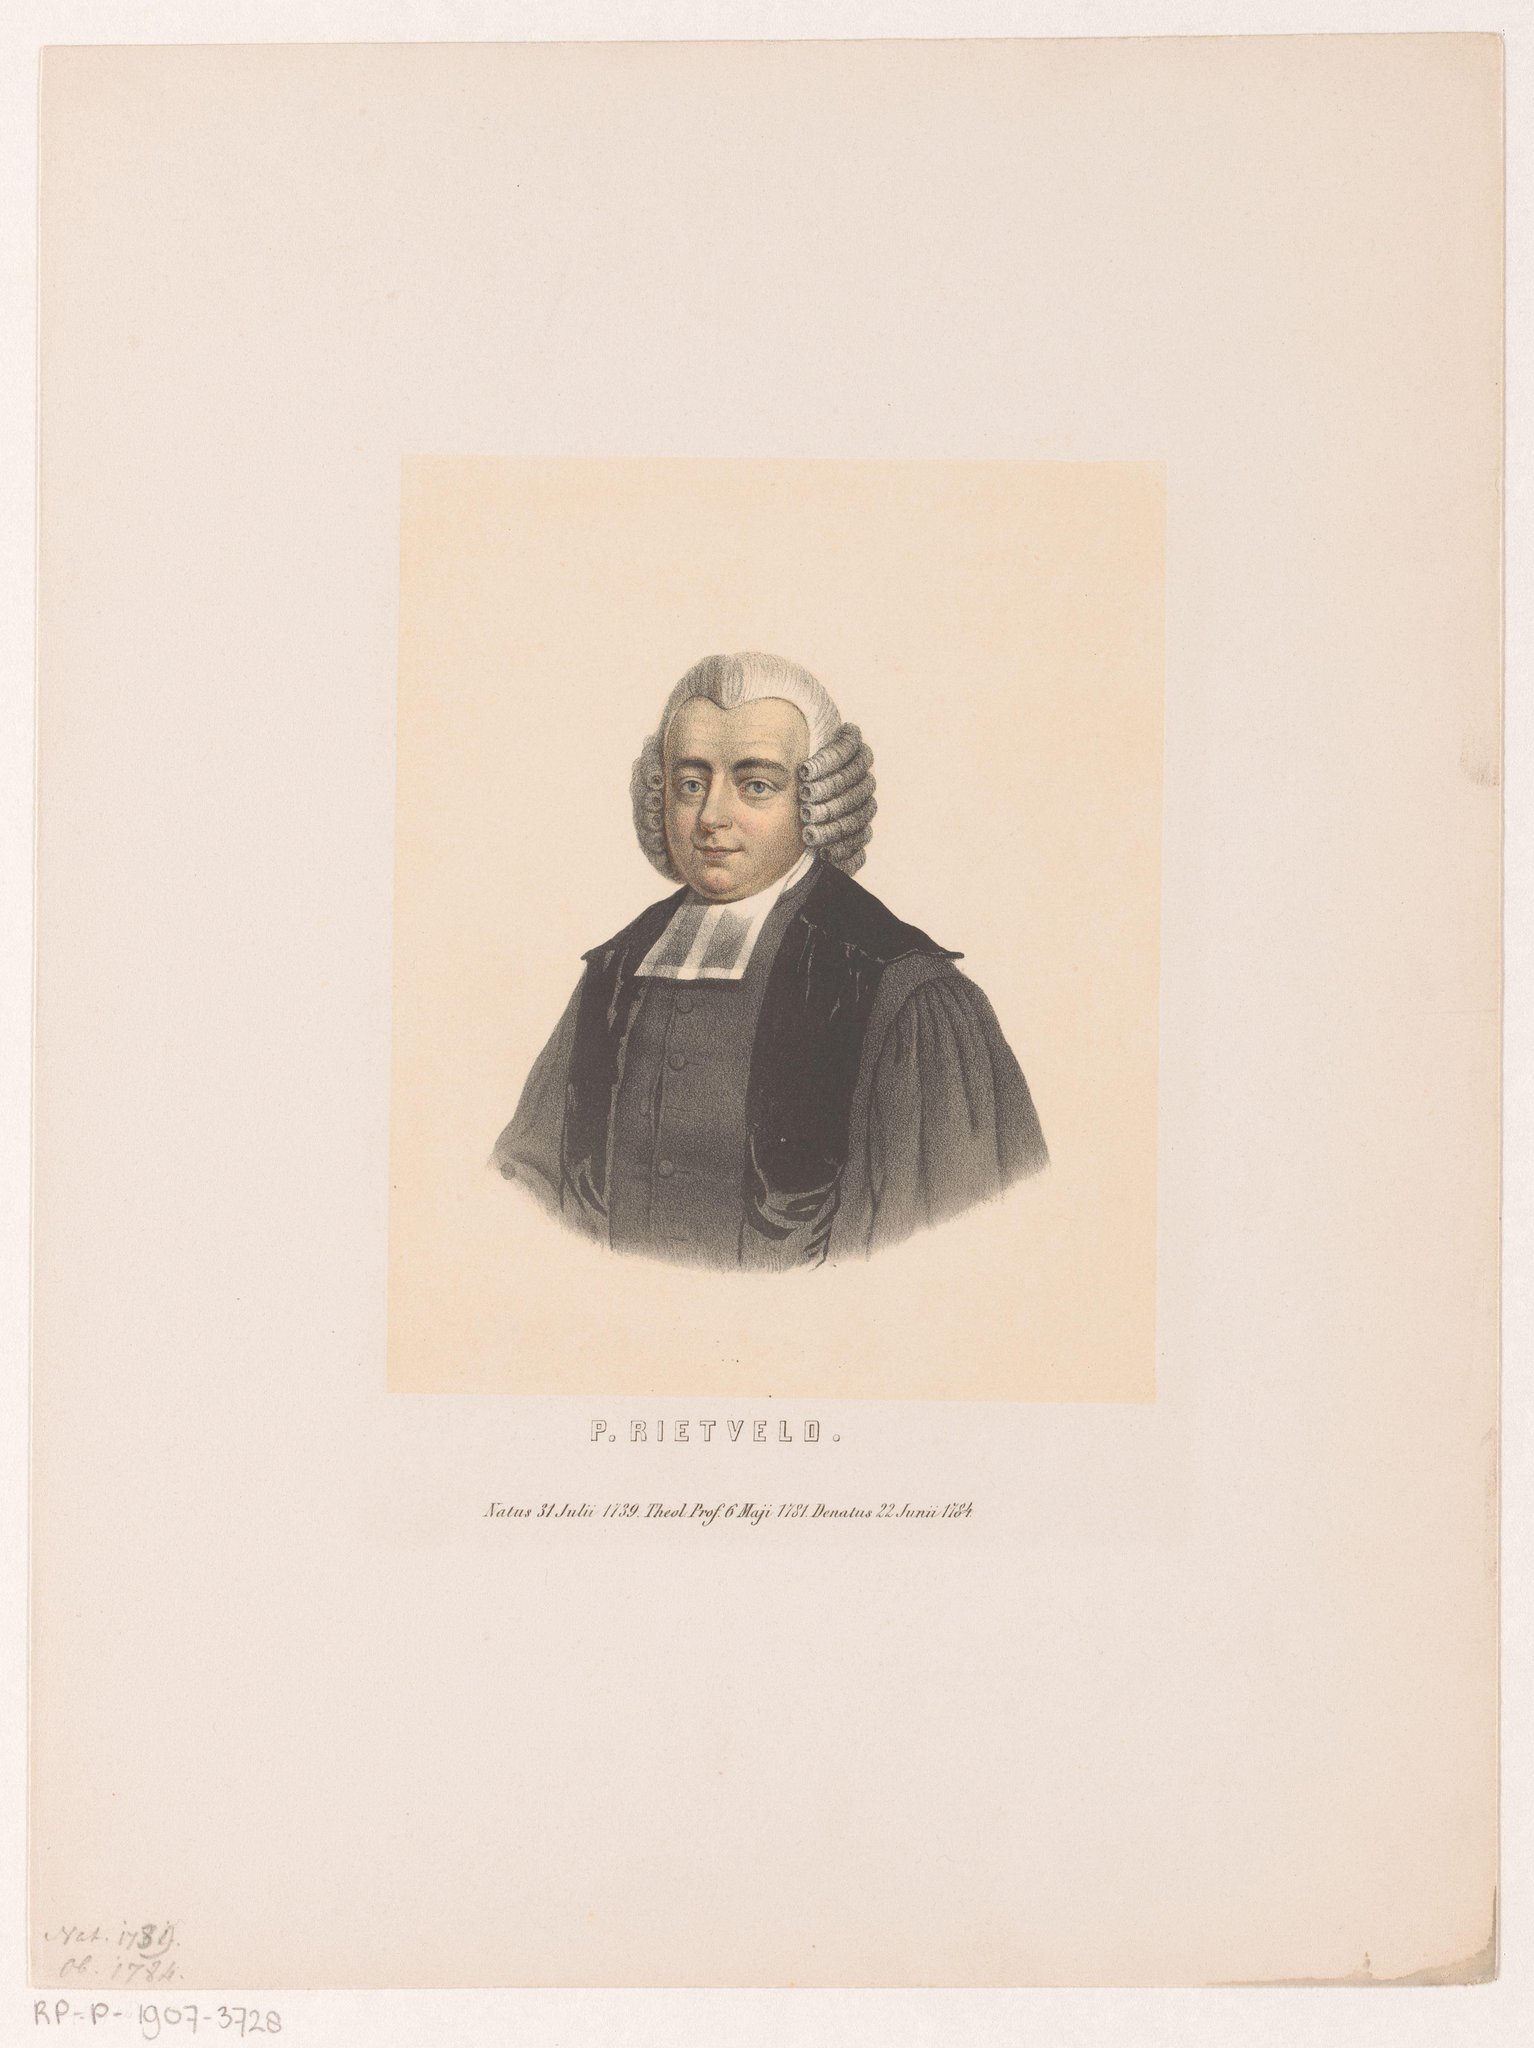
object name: print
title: Portret van Petrus Rietveld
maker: leendert springer (i)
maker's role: draughtsman, painter, print maker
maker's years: 1789-1871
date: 1850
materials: paper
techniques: lithograph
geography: leiden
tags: historical persons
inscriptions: collector's mark: Lugt 2228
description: Prent uit: Springer, Leendert. Galerij van hoogleeraren aan de Hoogeschool te Leijden, naar de oorspronkelijke afbeeldsels op de Senaat-zaal aldaar berustende. Leiden: Springer, Leendert., s.a. [circa 1850].